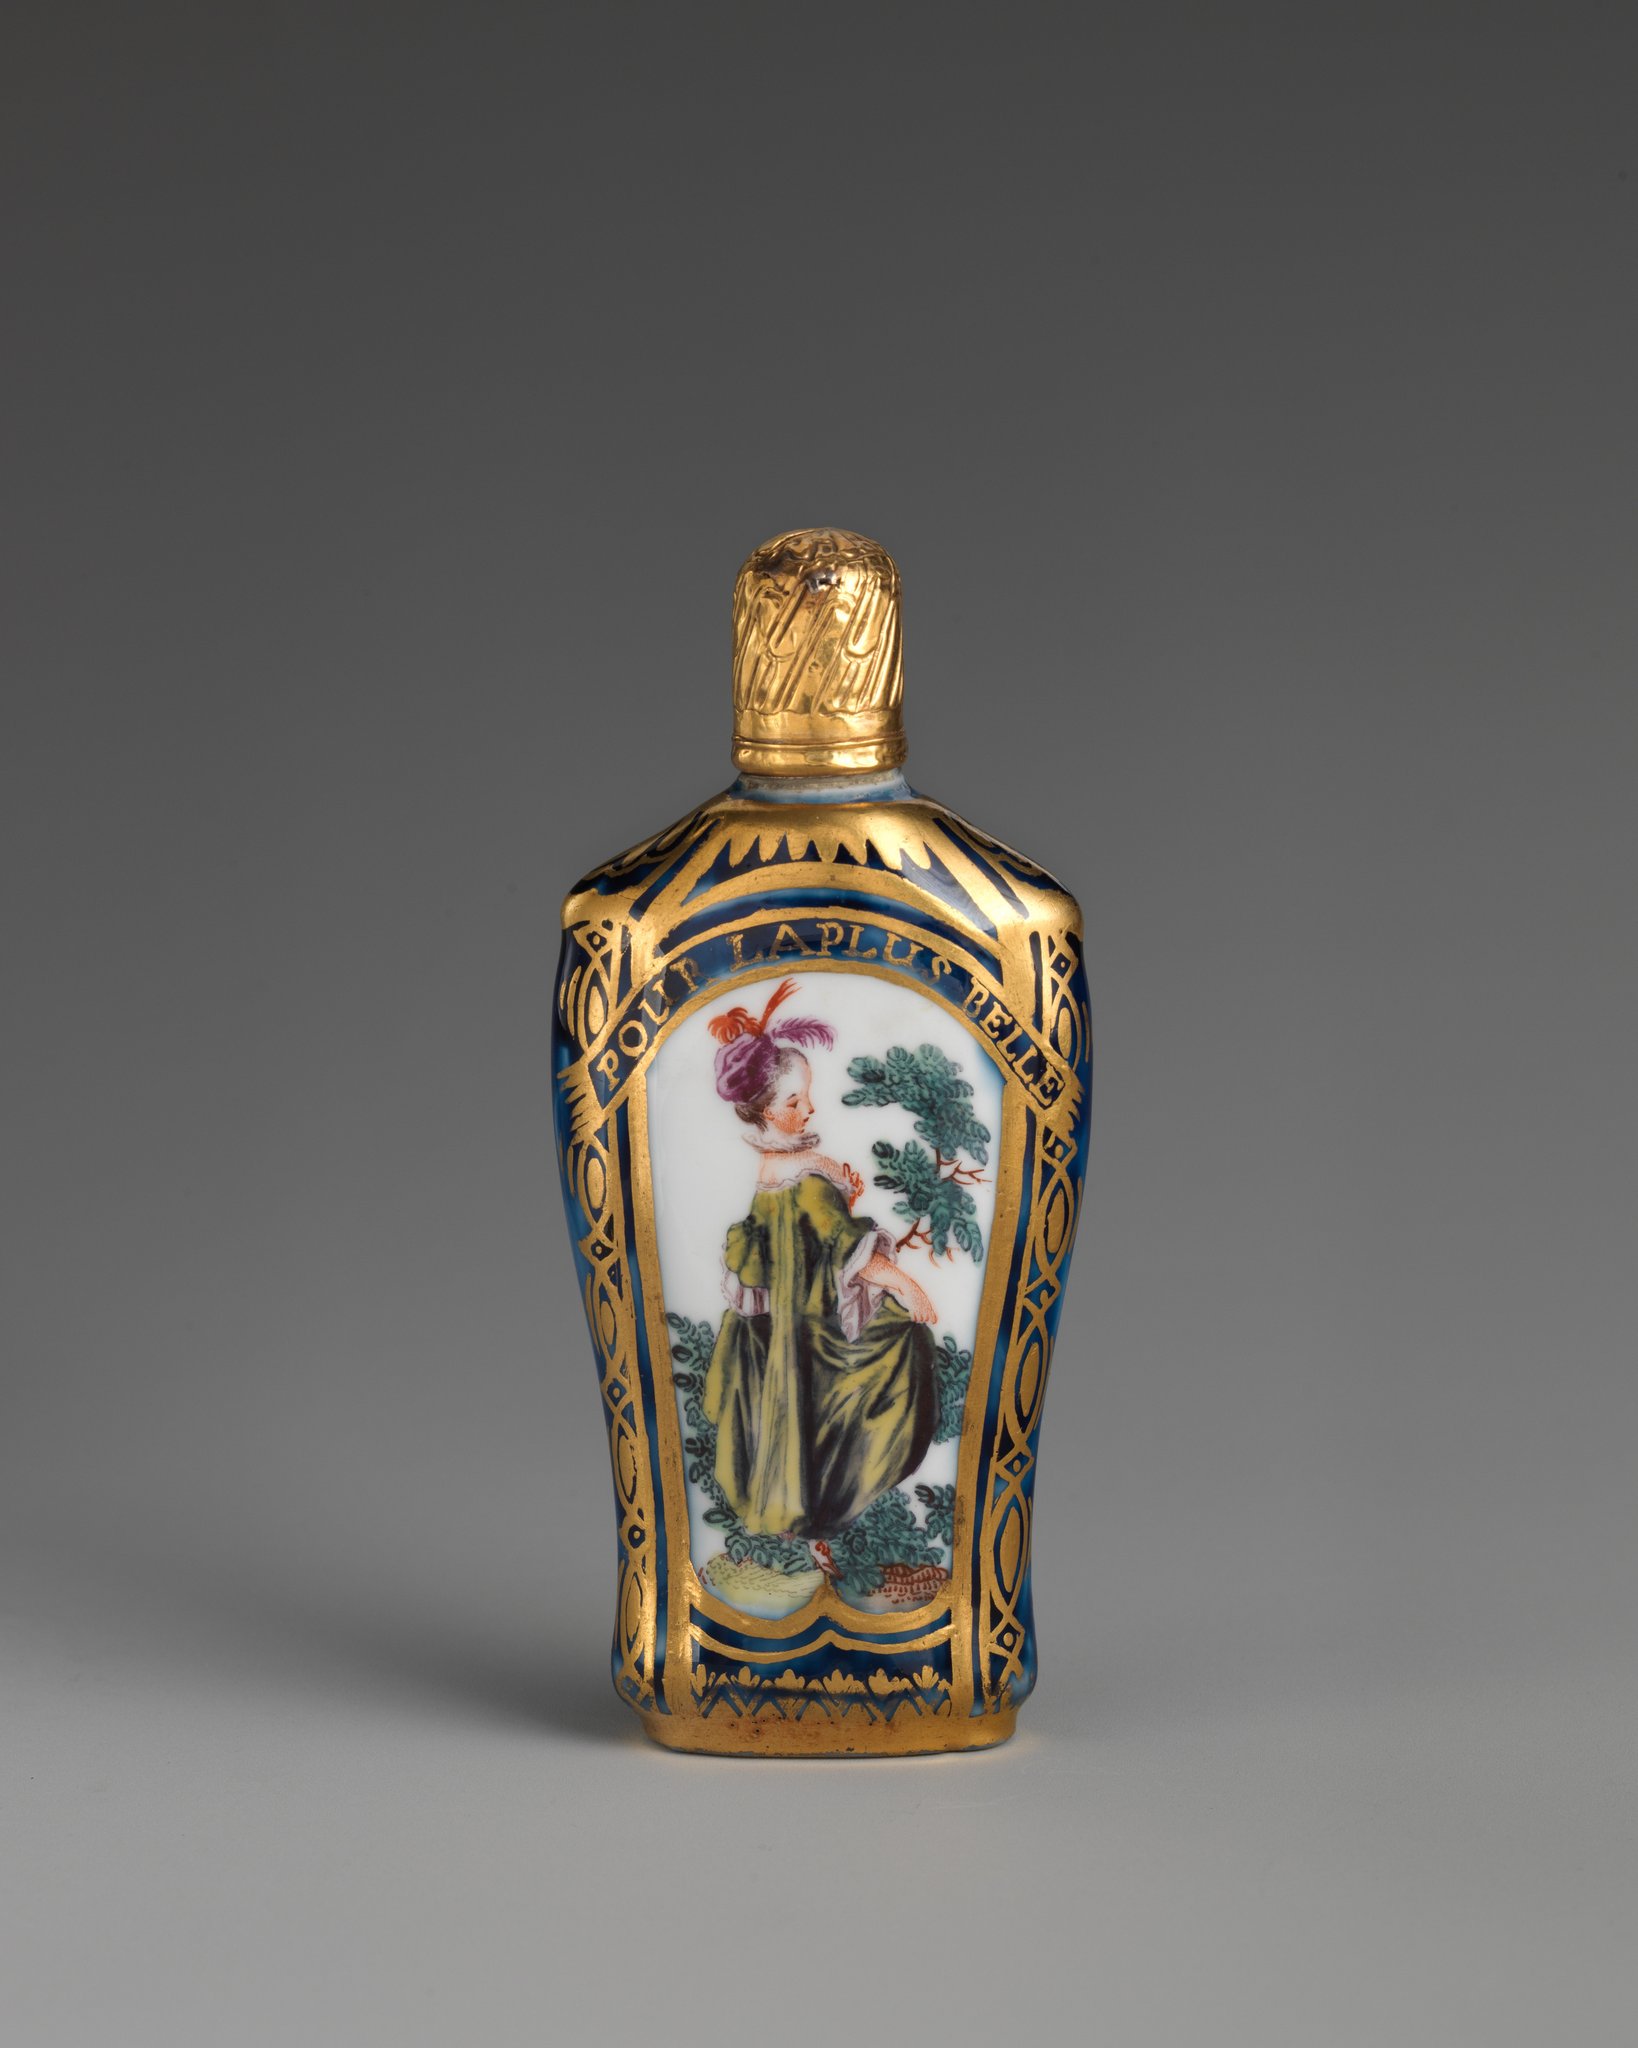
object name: toy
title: Flagon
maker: chelsea porcelain manufactory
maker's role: factory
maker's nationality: british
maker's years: 1744-1784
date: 1765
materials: soft paste porcelain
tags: women,trees